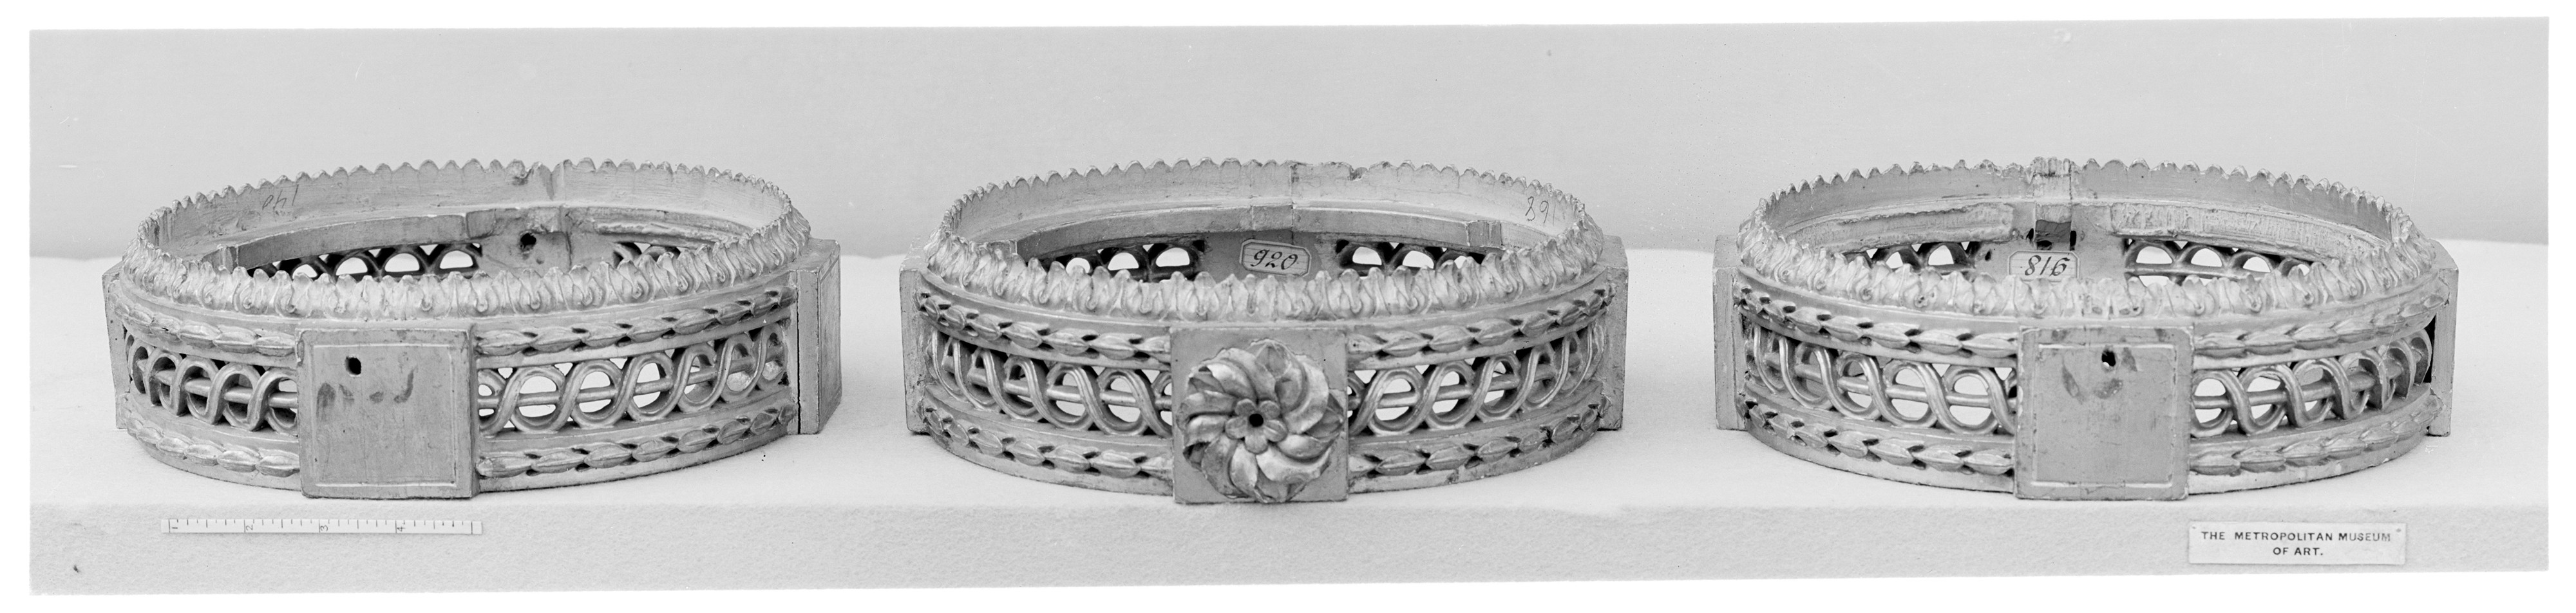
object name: support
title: Set of three supports (?)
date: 1701-1800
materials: gilt, wood